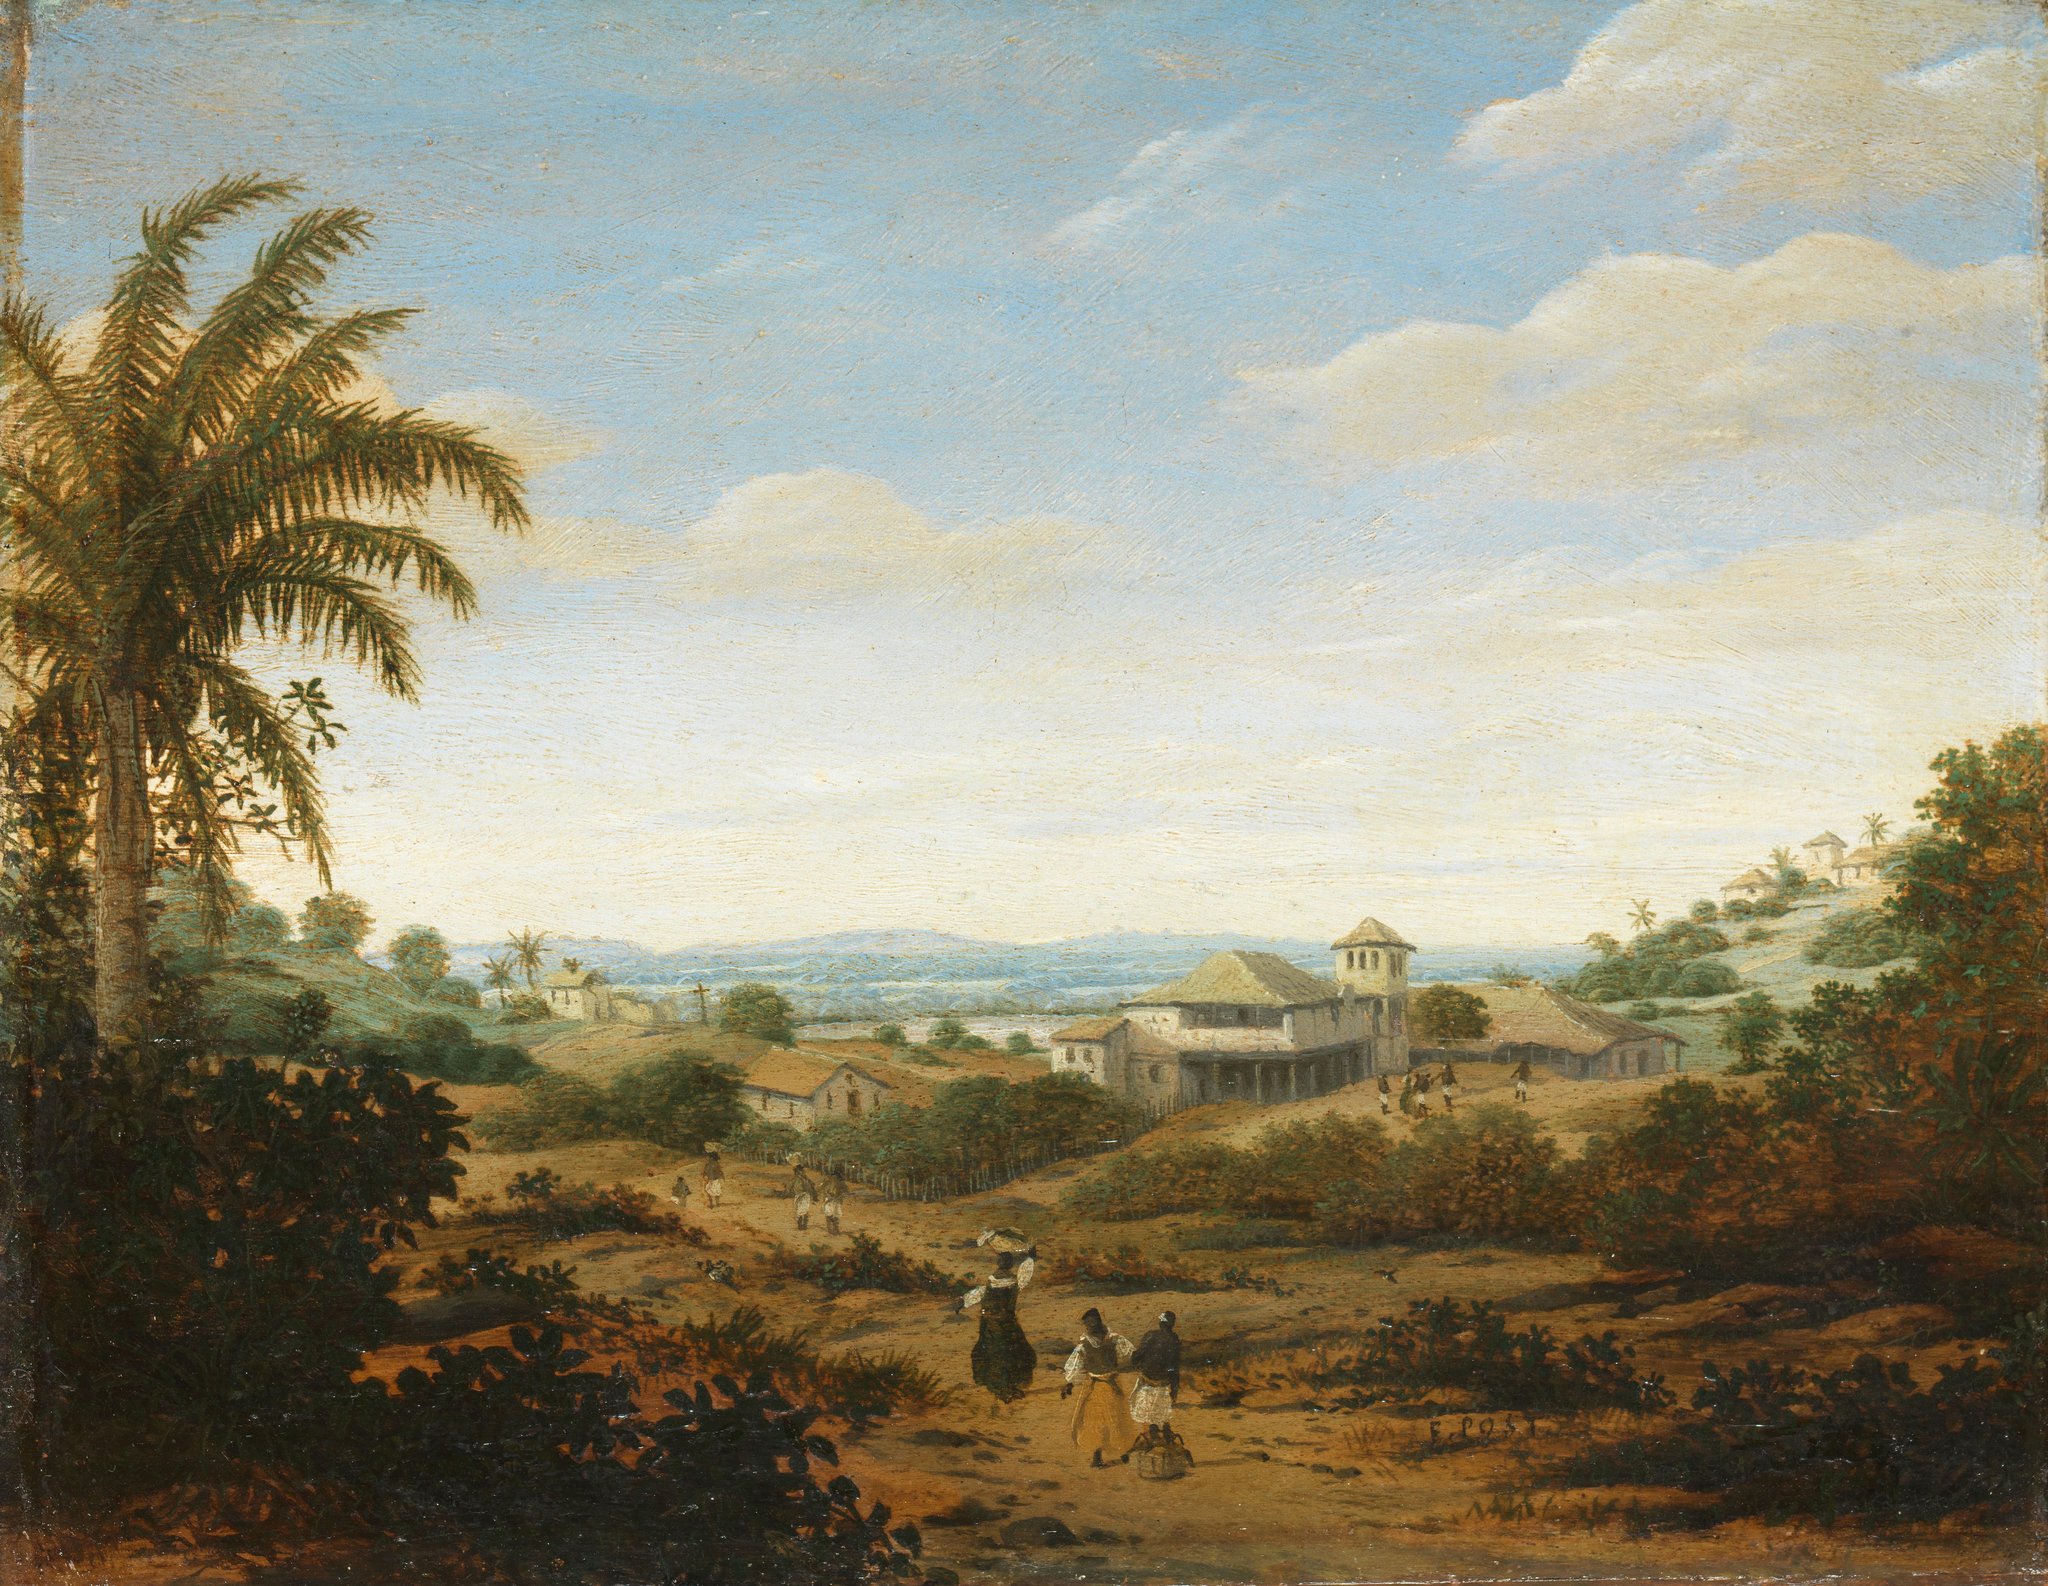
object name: painting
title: Sugar Factory with Tower House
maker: frans jansz post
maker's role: painter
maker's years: 1612-1680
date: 1670-1680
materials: oil, panel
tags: landscapes in tropical and sub-tropical regions, brasil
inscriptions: signature: ‘F. Post’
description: This painting and the Brazilian landscape on view next to it are part of a series of landscapes that Frans Post painted on his return to the Netherlands from Brazil in 1644. The foreground figure carrying a basket on her head recurs regularly in his work.